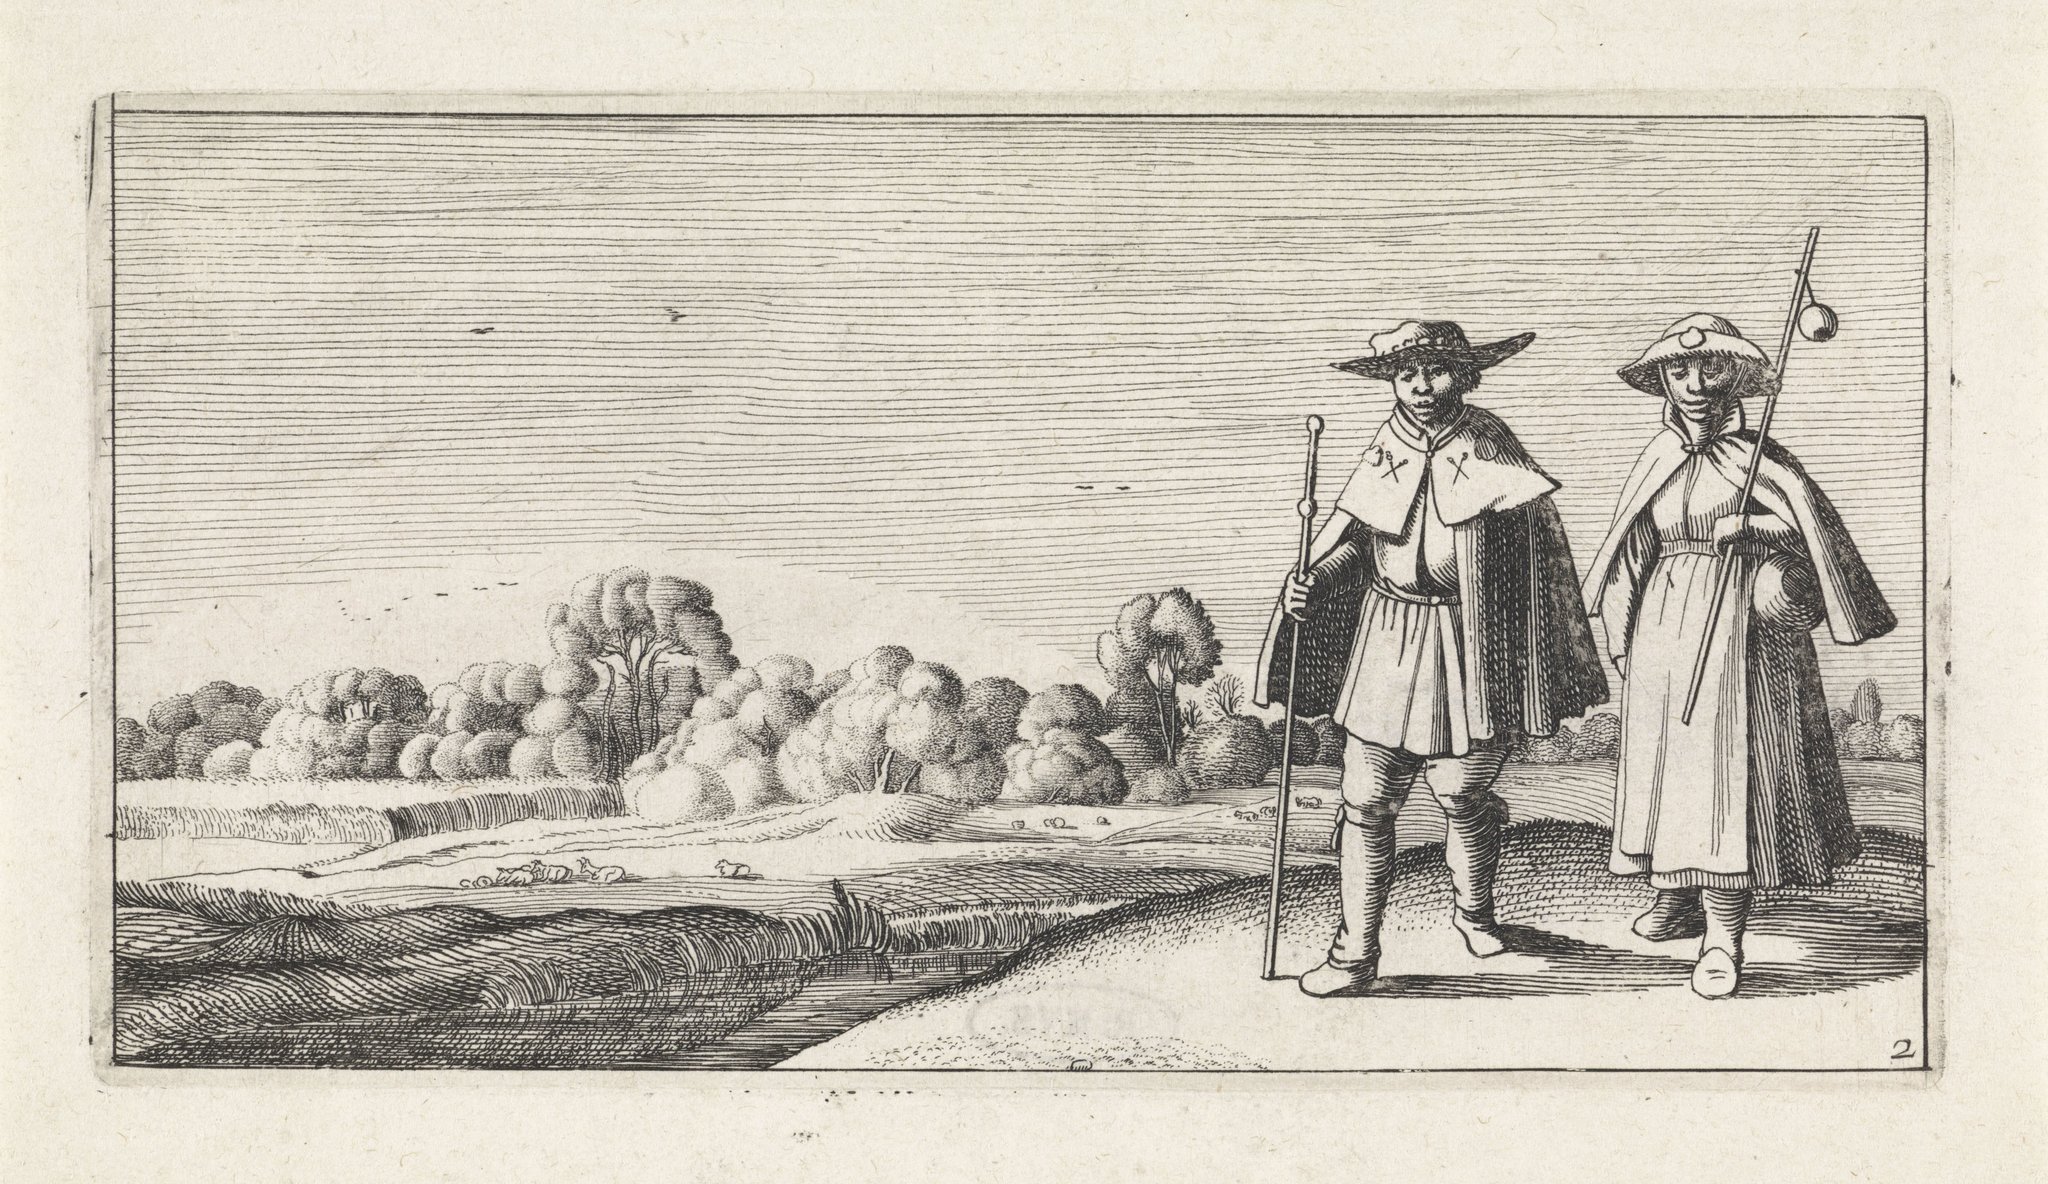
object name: print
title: Vita brevis, spes longa homini, caecusq meatus Pars inopes mundi quantu lacunque sumus, kopieën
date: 1603-1652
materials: paper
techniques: etching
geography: amsterdam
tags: pilgrim(s), meadow, pasture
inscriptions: collector's mark: Lugt 964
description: Een mannelijke en een vrouwelijke pelgrim in een weidelandschap. Tweede prent uit een serie van zes.